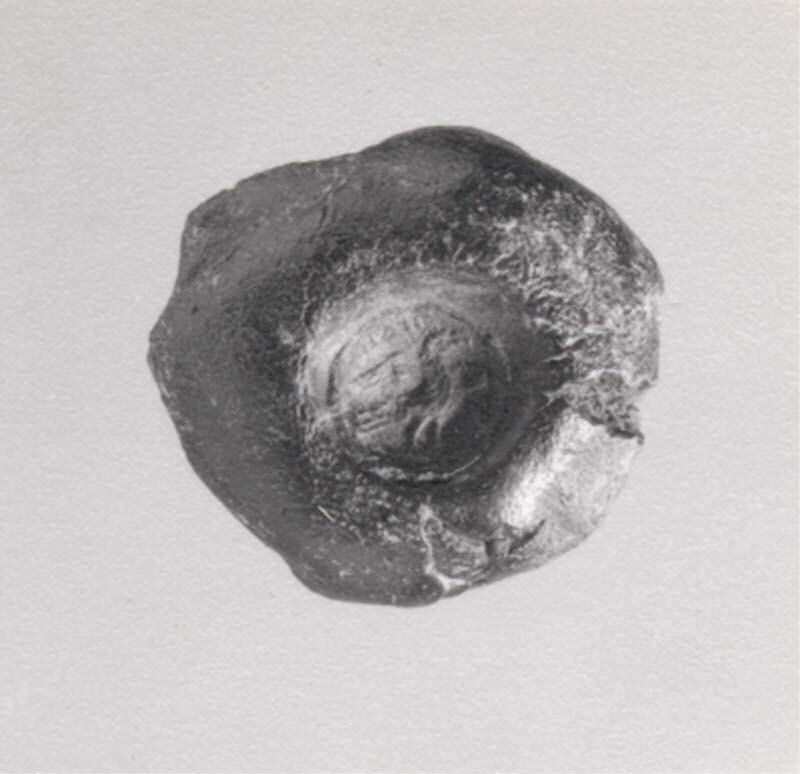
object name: sealing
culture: sasanian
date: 601-700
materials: clay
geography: iran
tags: birds